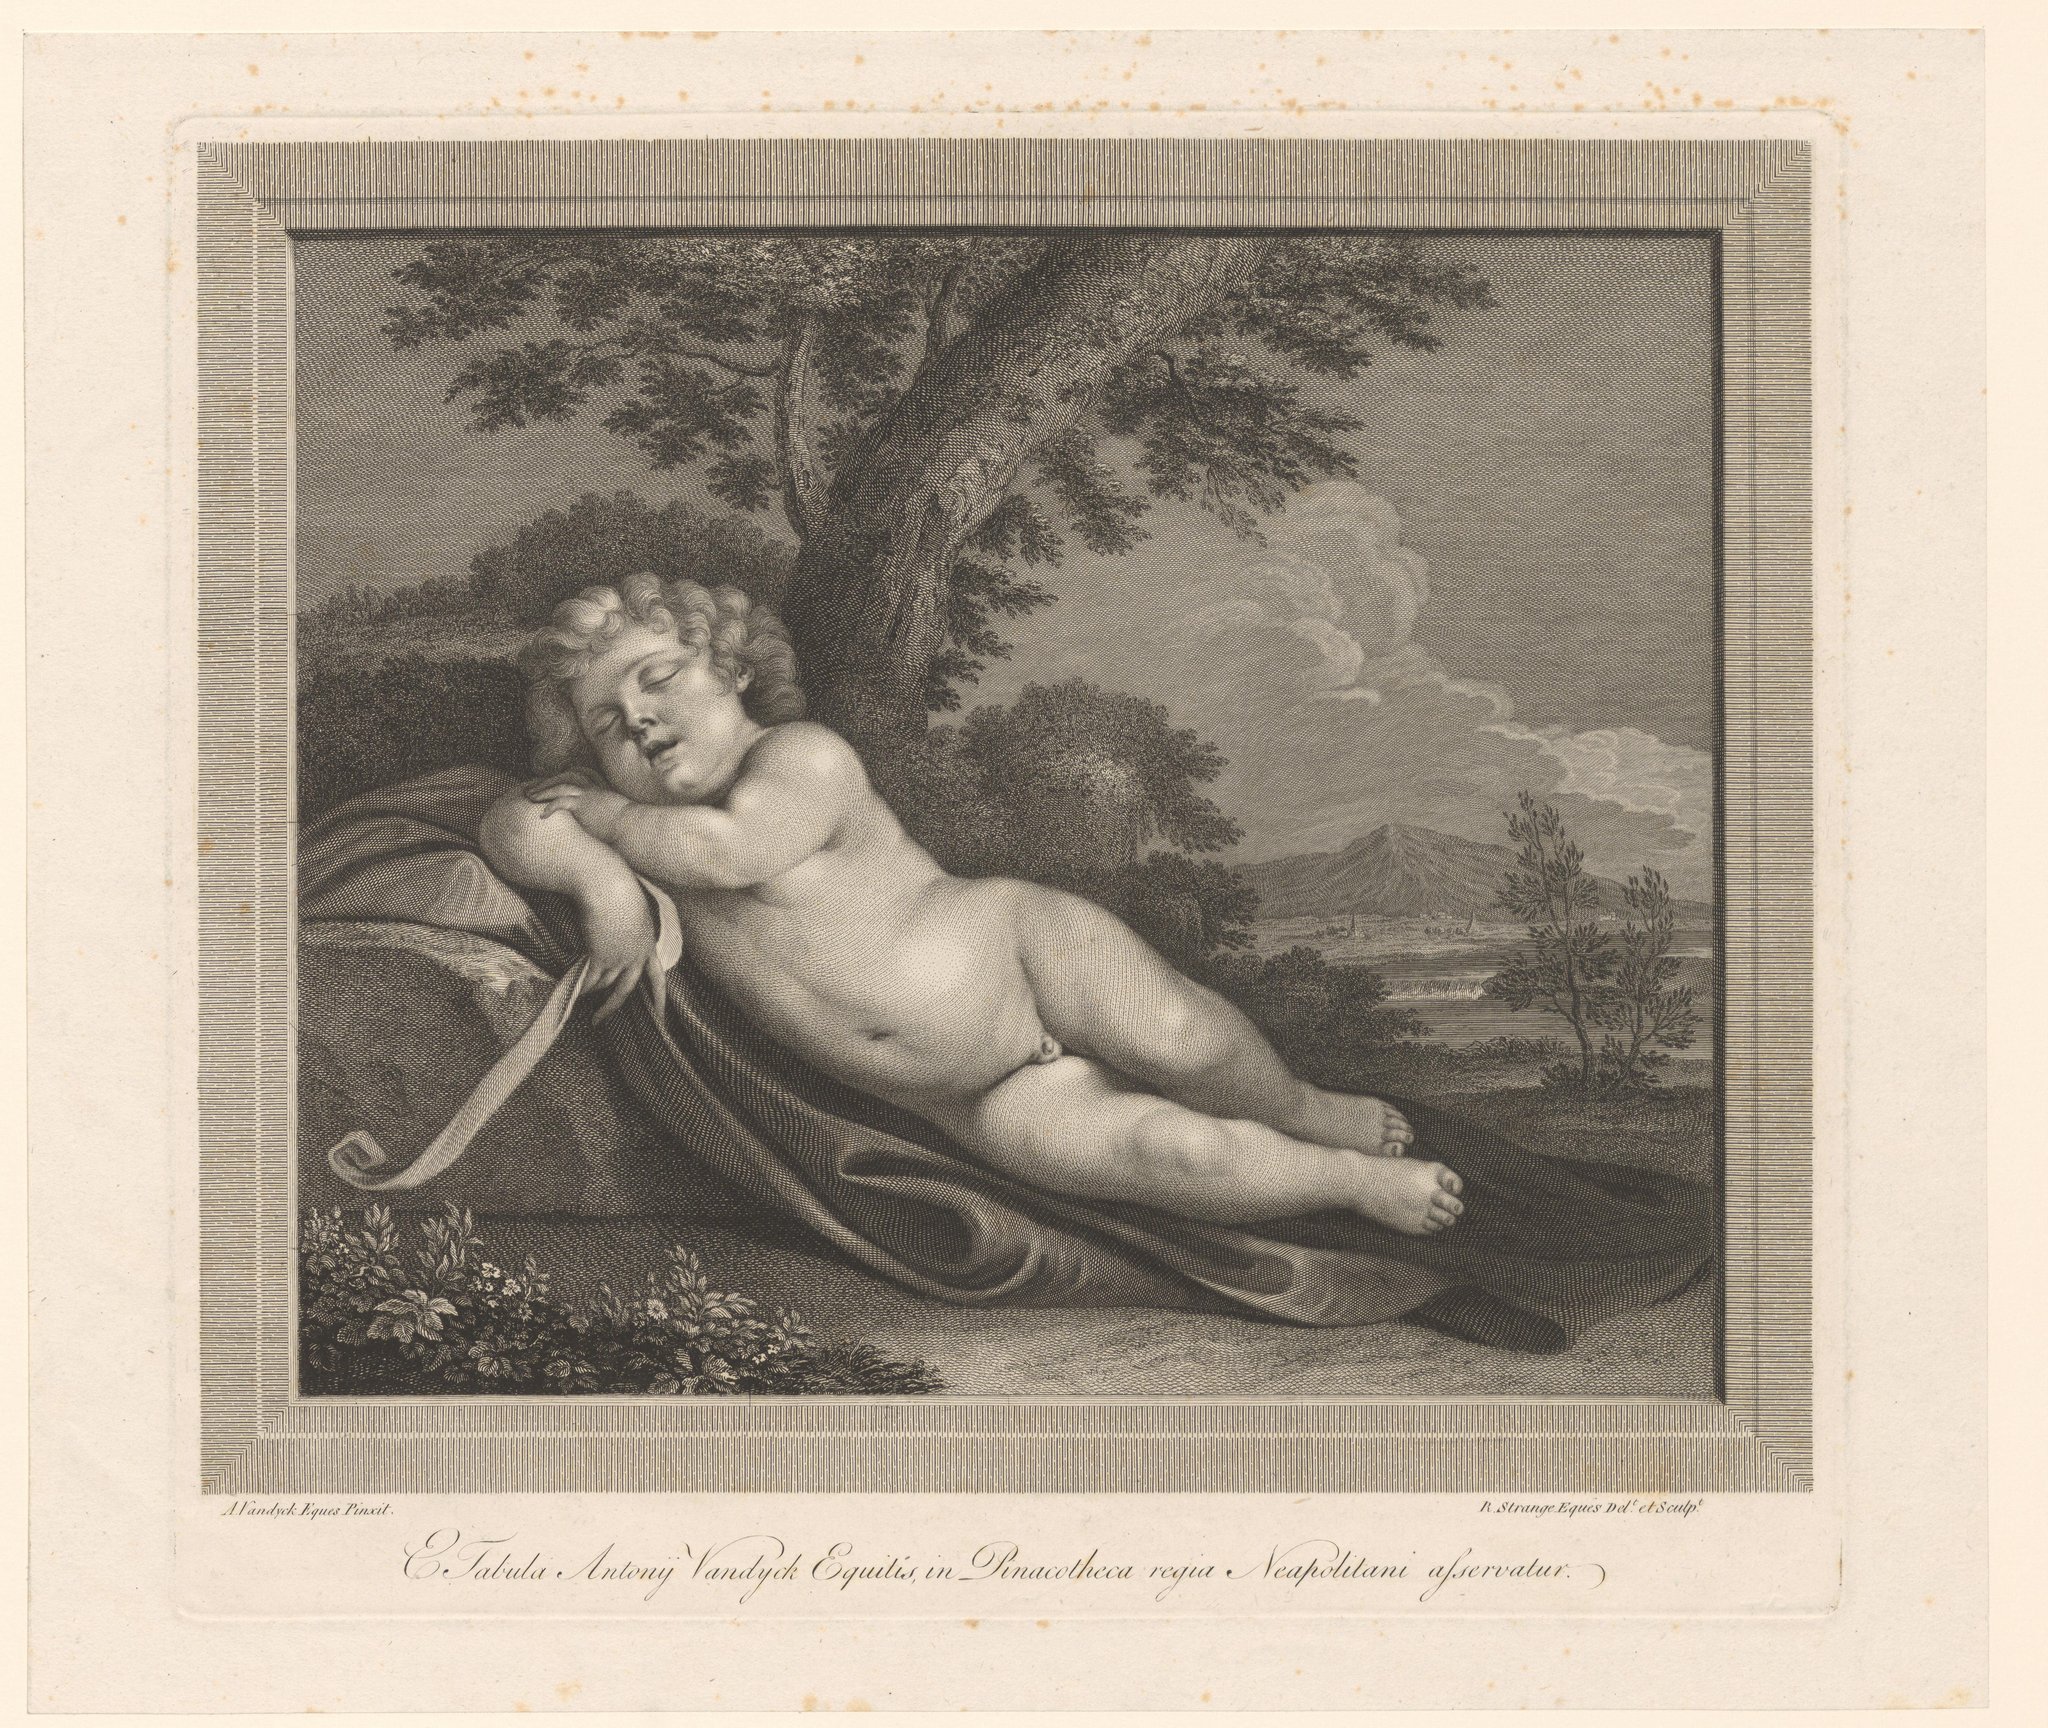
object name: print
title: Landschap met slapende Johannes de Doper als kind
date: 1787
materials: paper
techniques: engraving, etching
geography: london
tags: toddler, sleeping on the ground - bb - out of doors, series of scenes from the life of john the baptist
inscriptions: collector's mark: Lugt 2228